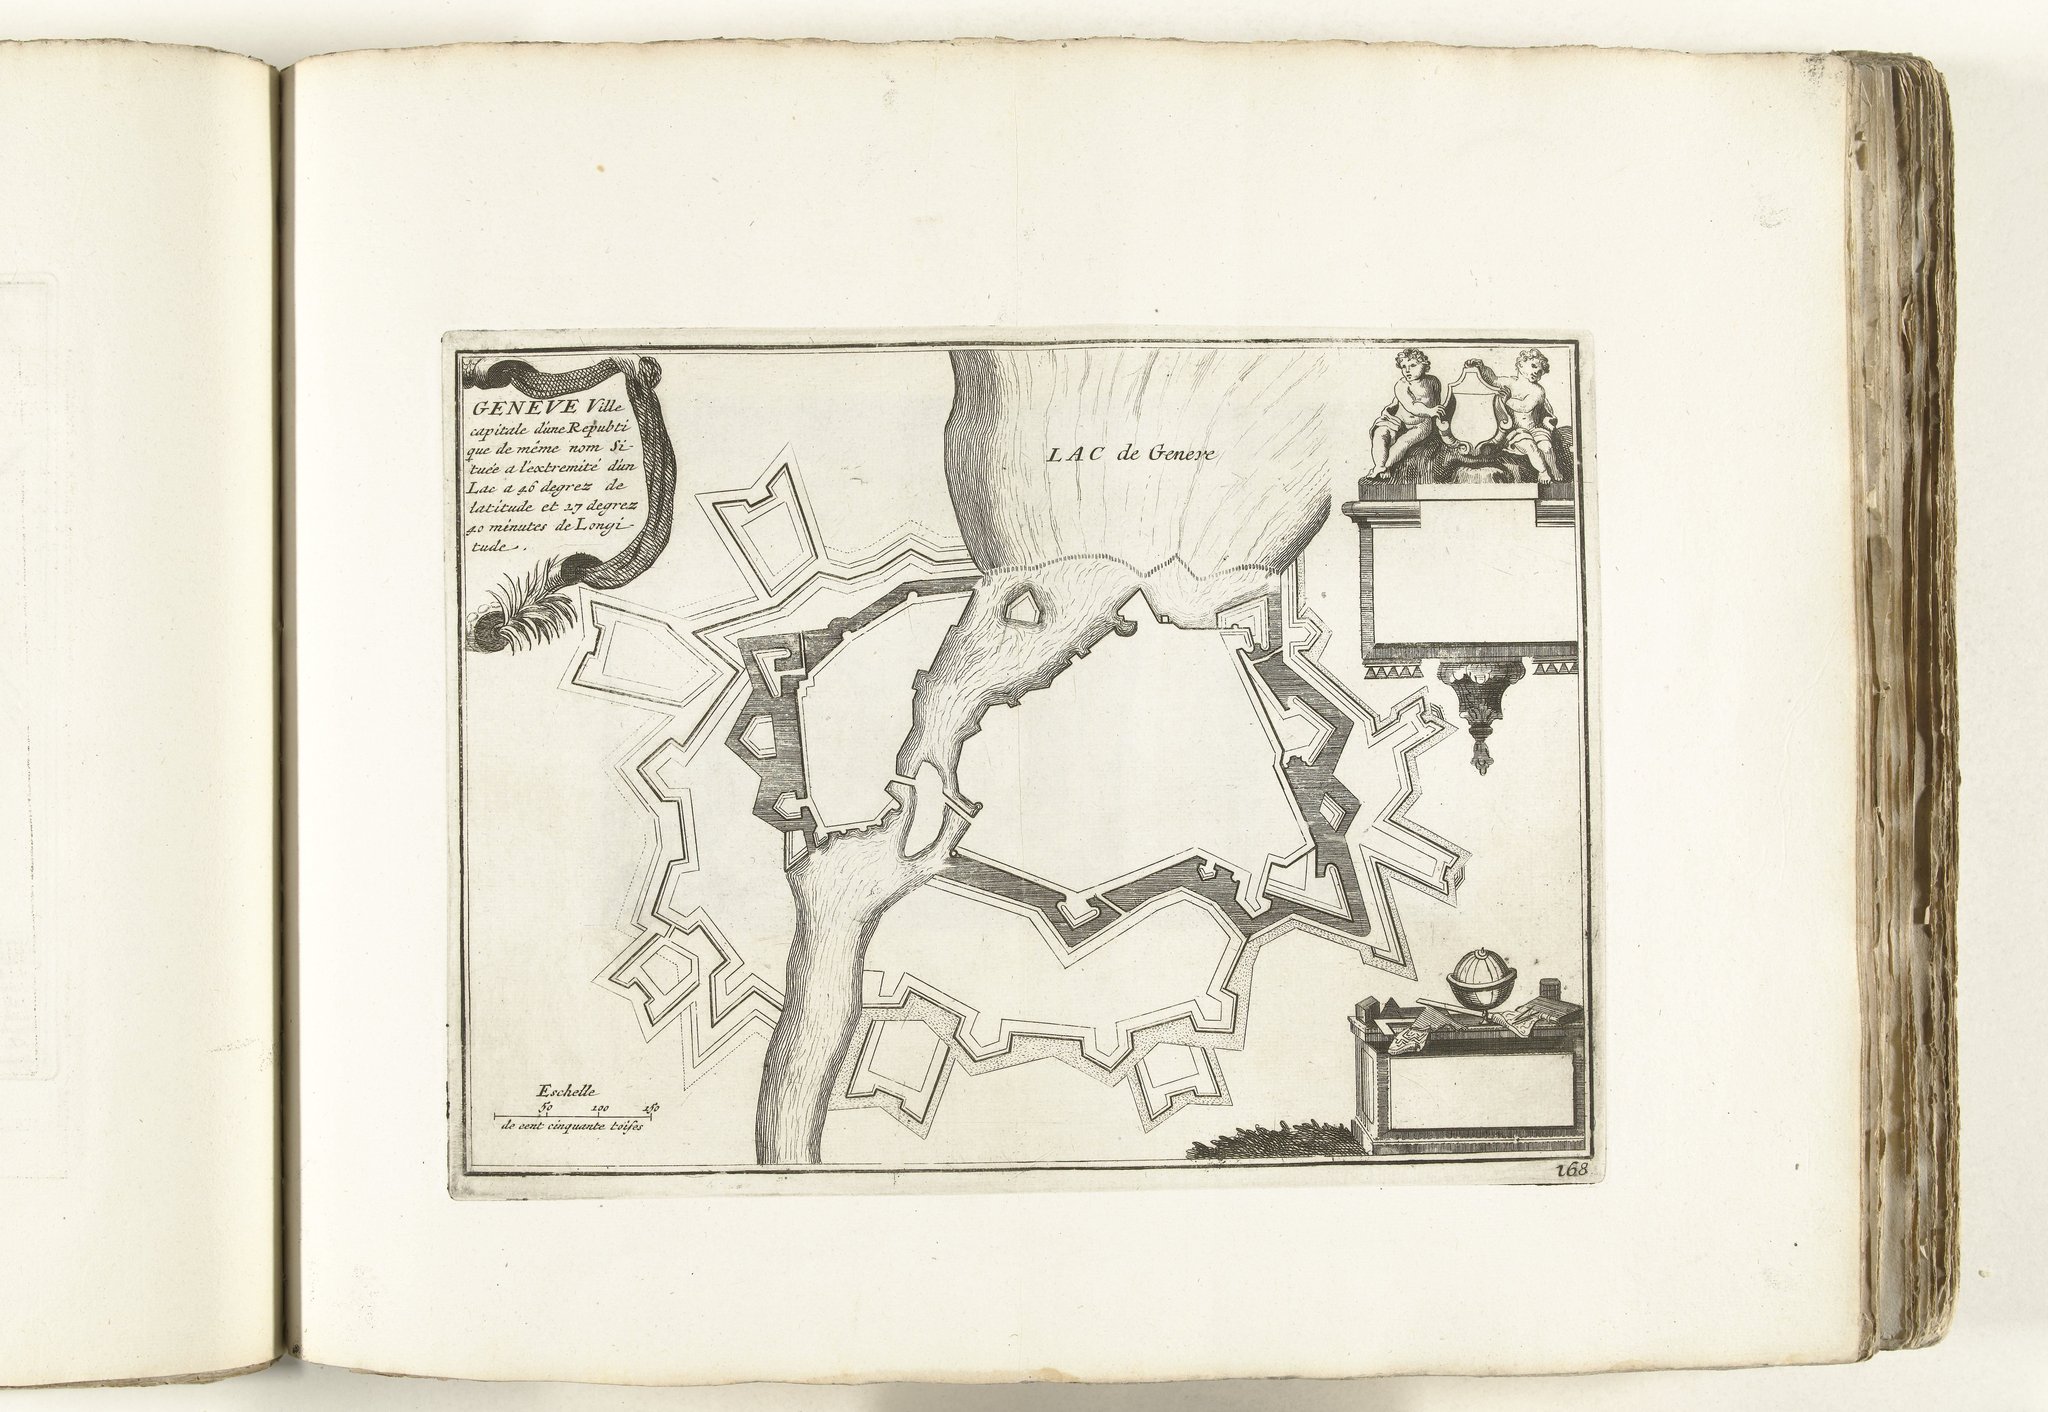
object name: print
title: Geneve Ville capitale d'une Republique de même nom (...)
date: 1702-1703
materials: paper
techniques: etching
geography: amsterdam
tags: fortress, maps of cities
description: Plattegrond van de versterkingen om de Zwitserse stad Genève. Plaat nr. 168 in het prentwerk bestaande in totaal uit 276 genummerde platen van vermaarde sterke steden en vestingen in het kader van de Spaanse Successieoorlog. Voor het merendeel zijn deze platen gekopieerd naar de anonieme Franse platen: in Les forces de l'Europe en in: Le theatre de la guerre, dans les Pays-Bas, beide oorspronkelijk uitgegeven door Nicolas de Fer te Parijs (1693-1697) in het kader van de Negenjarige Oorlog. Titel en opschriften in de plaat in het Frans.